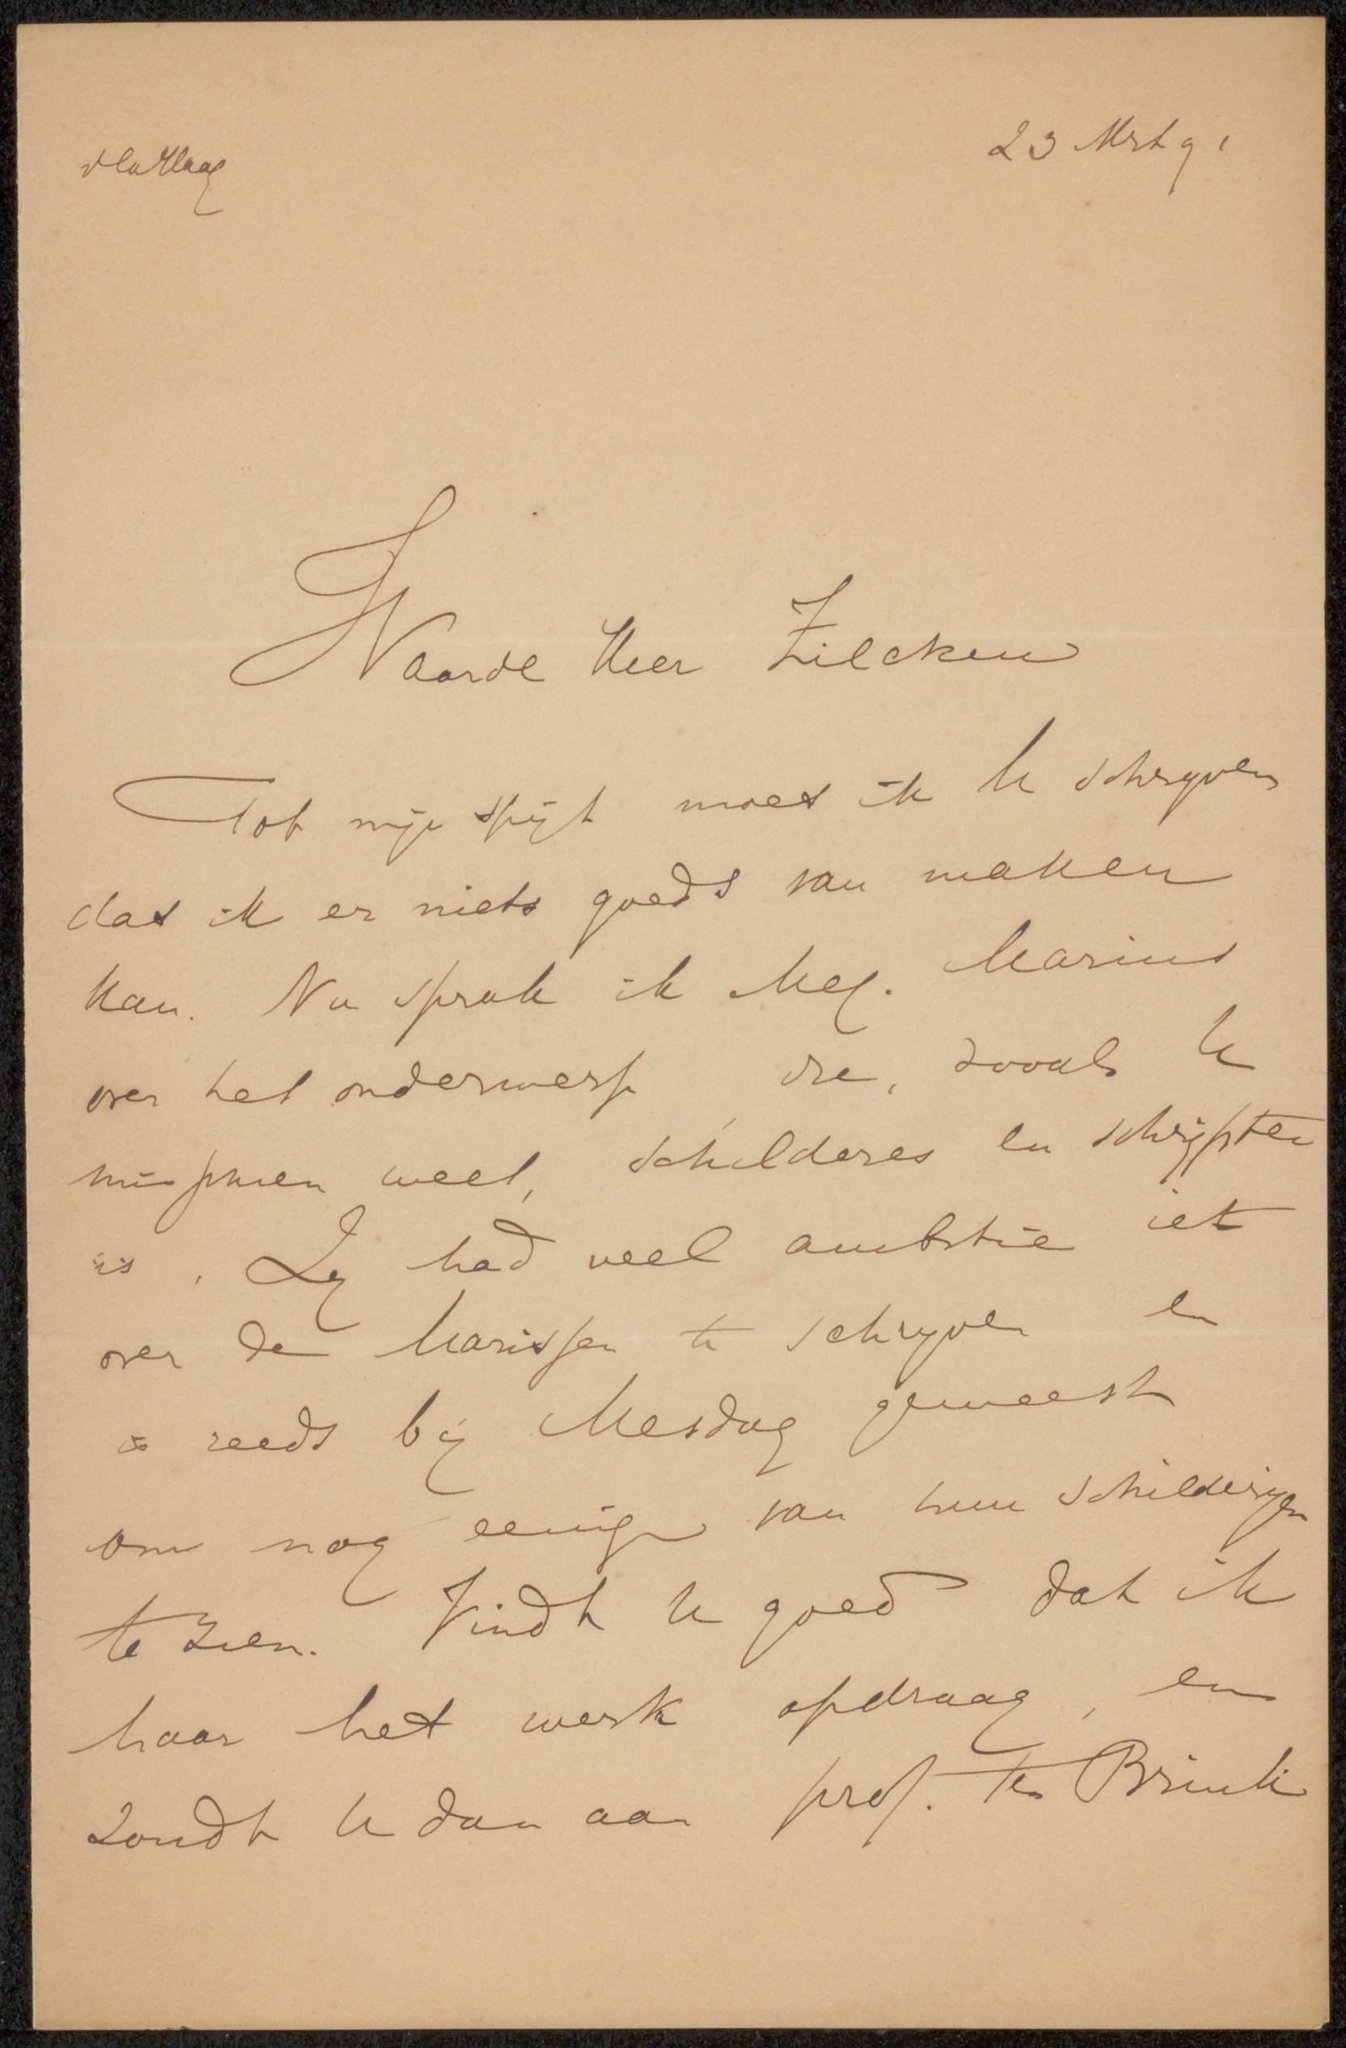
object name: letter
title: Brief aan Philip Zilcken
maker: josephine giese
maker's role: auteur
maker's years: 1856-1926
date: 1891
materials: ink, paper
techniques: pen, writing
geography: the hague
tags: hendrik willem mesdag, london, print maker, draughtsman, matthijs maris, willem maris, jacob maris, leiden, jan ten brink (1834-1901), the hague, painter, grada hermina marius, philip zilcken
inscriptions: collector's mark: ‘RPK’